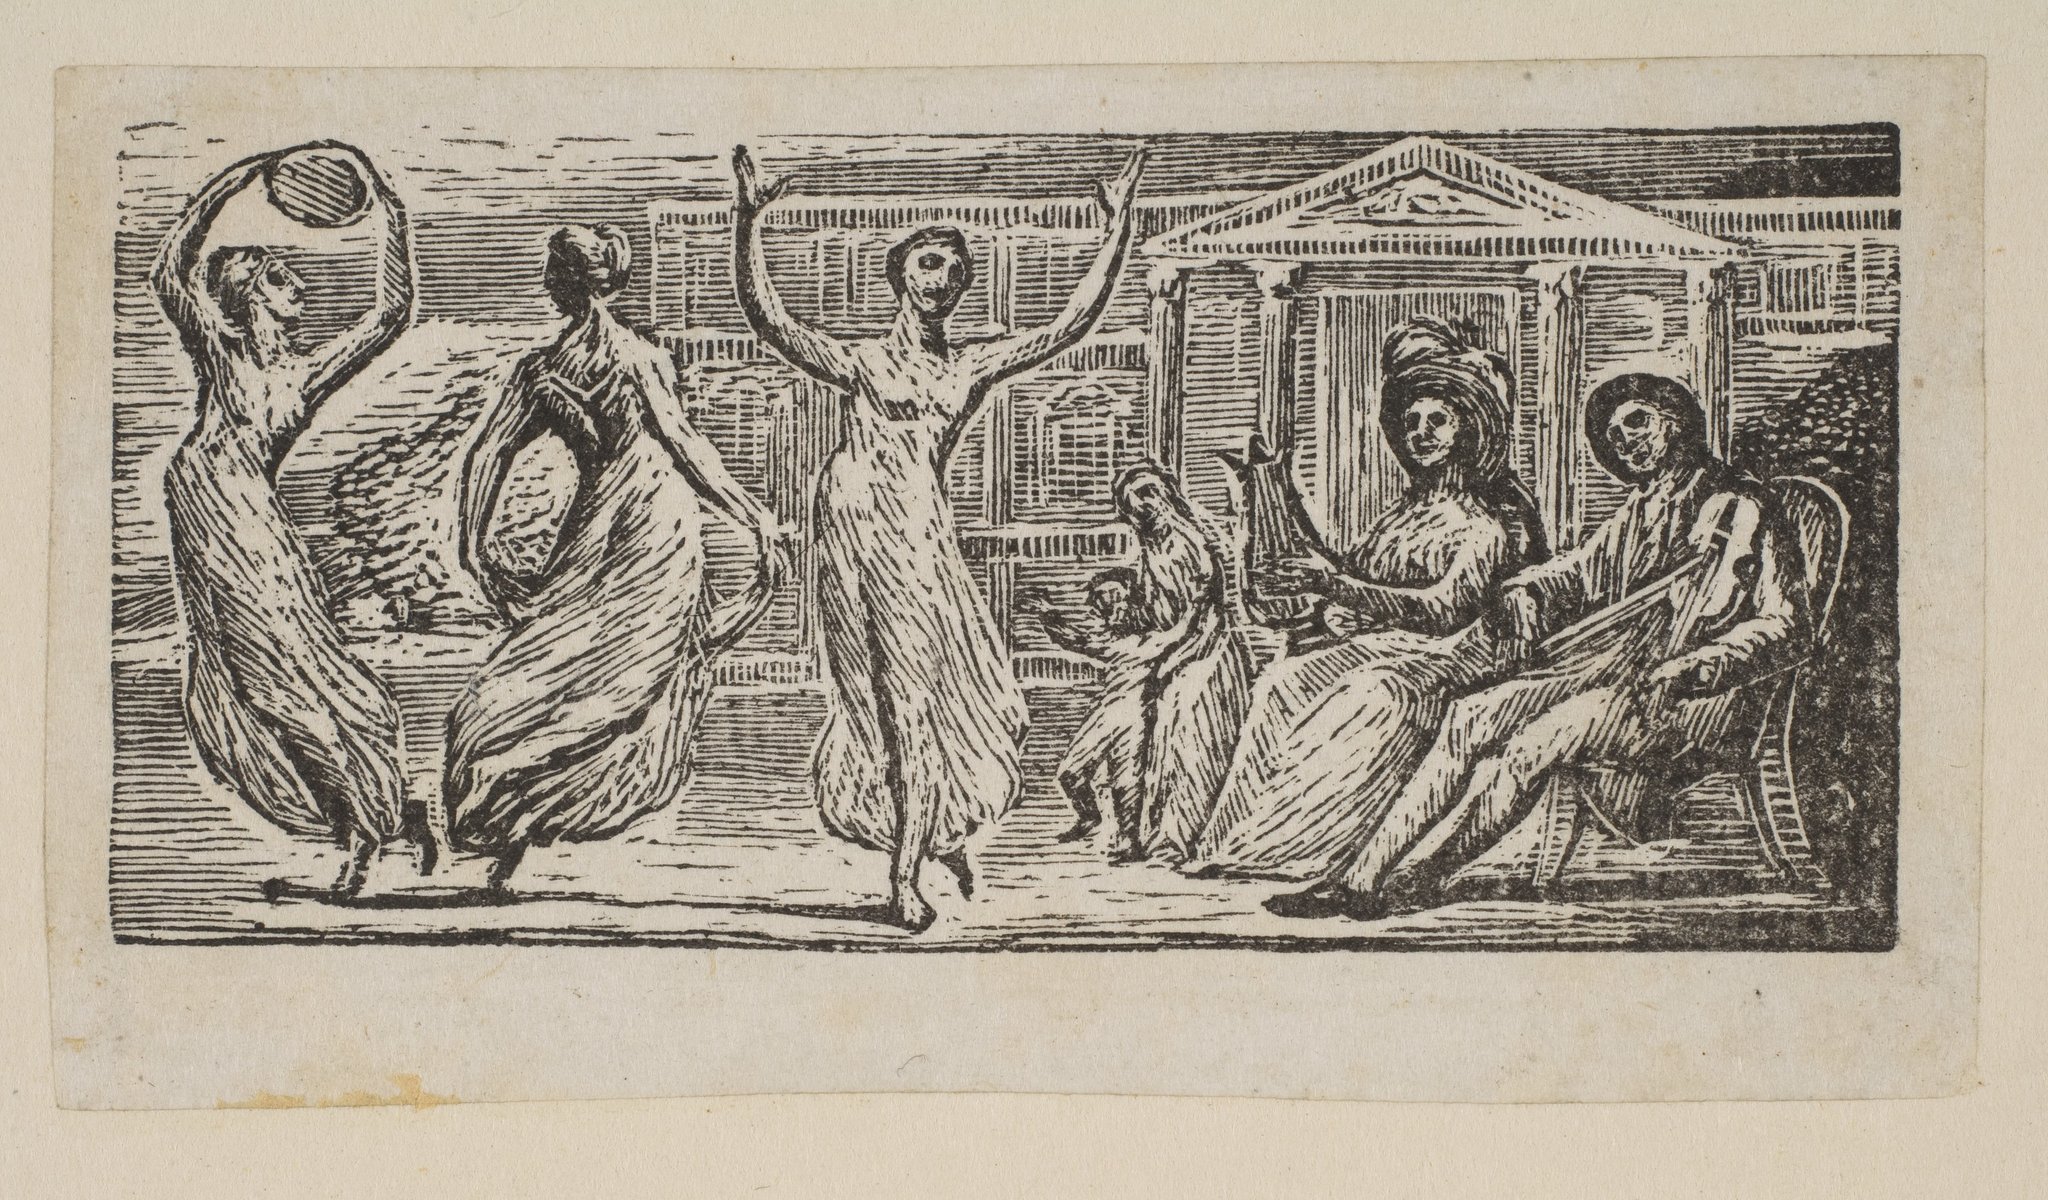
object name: print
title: Menalcus Watching Women Dance, from Thornton's "Pastorals of Virgil"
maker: william blake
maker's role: artist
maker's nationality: british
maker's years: 1757-1827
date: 1821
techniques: engraving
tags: musical instruments,men,women,dancing,musicians